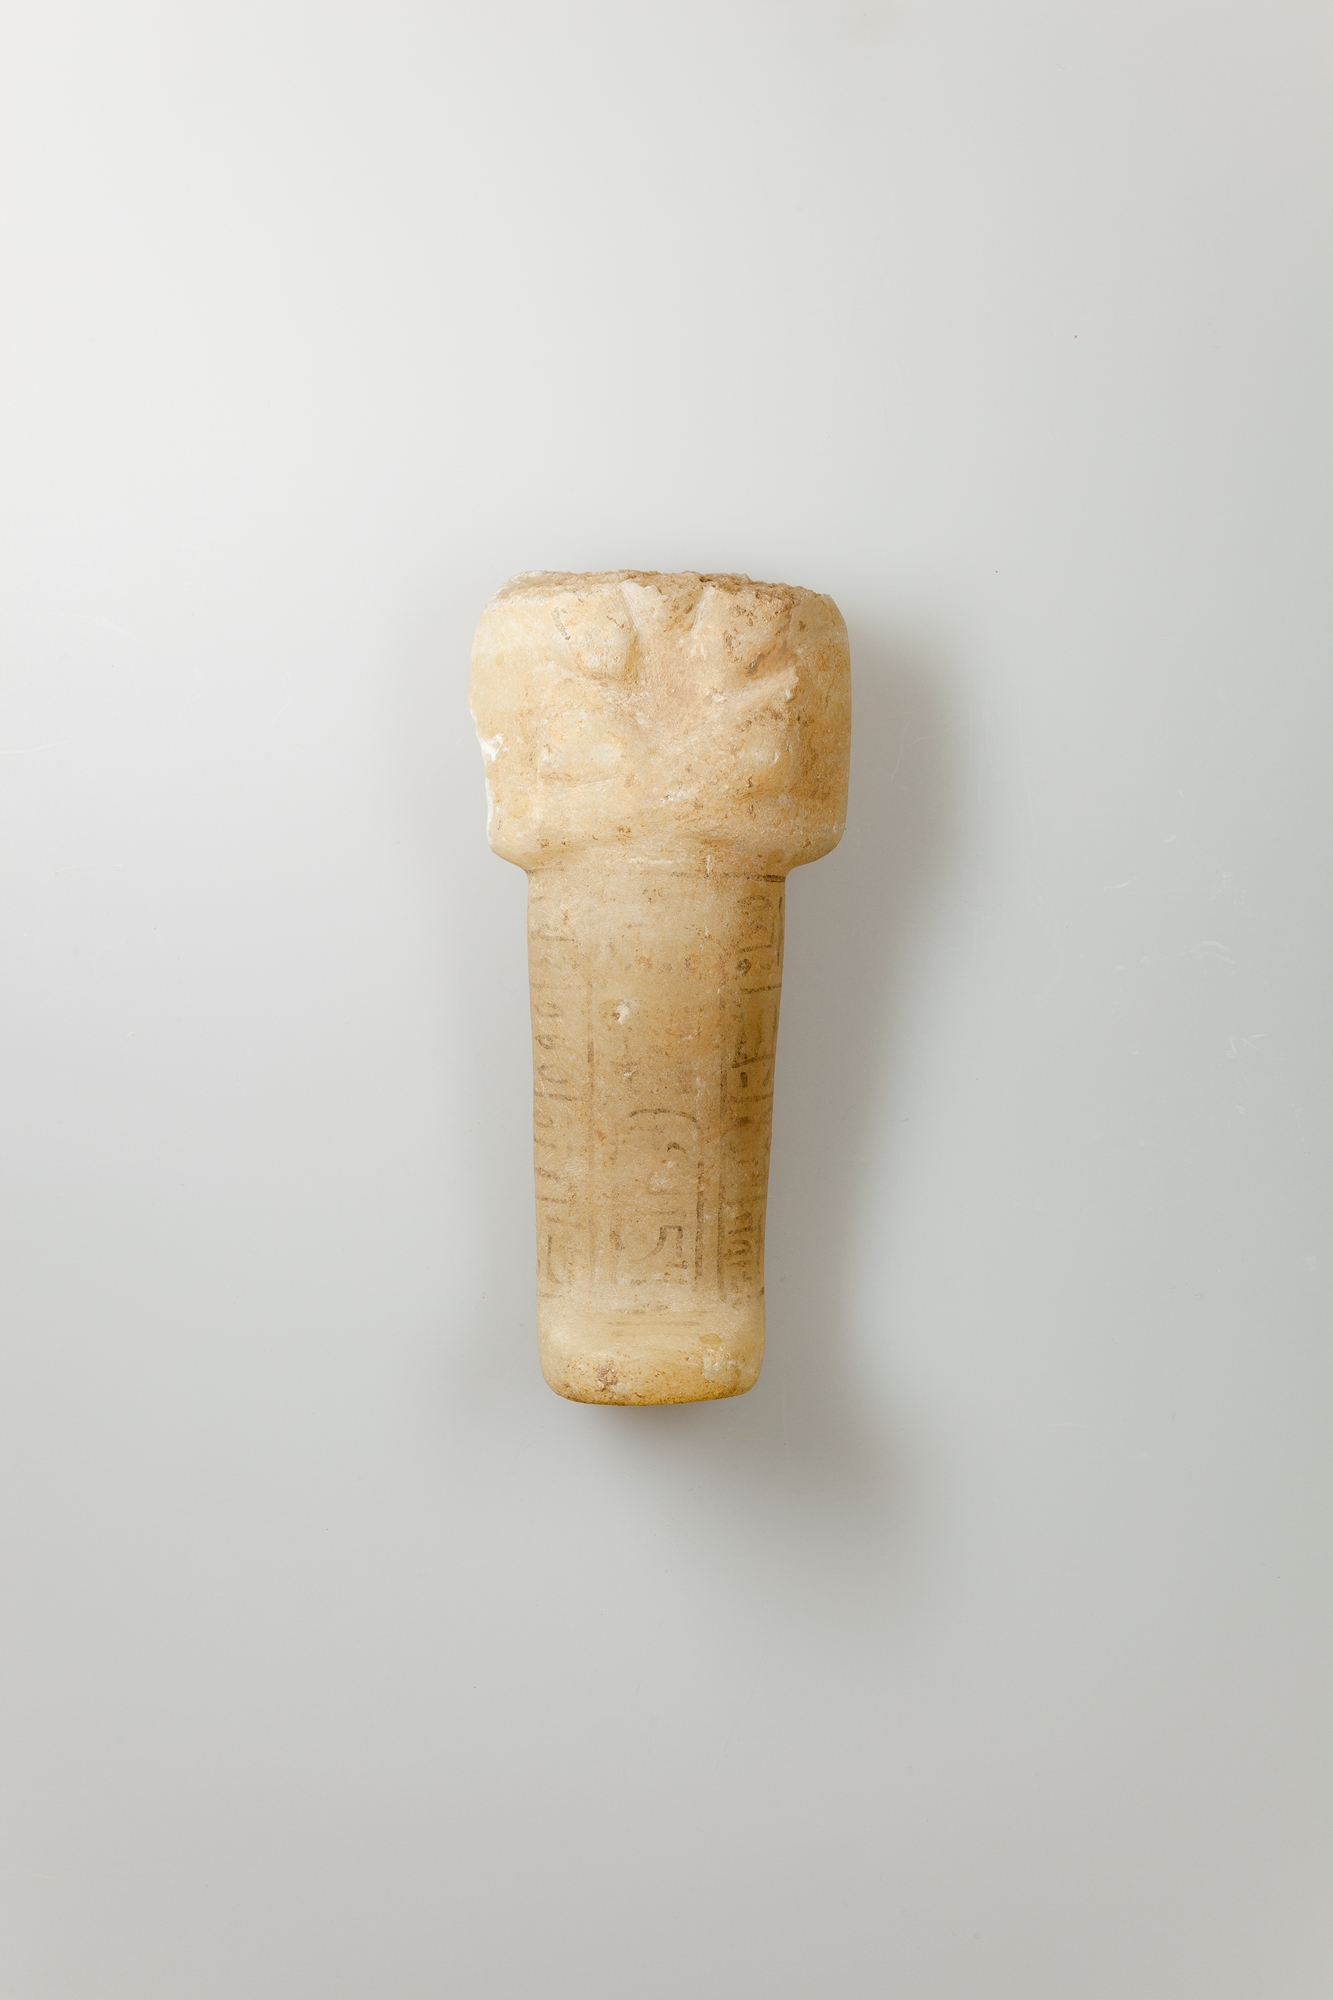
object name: shabti, siptah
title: Shabti of Siptah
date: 1194-1188 BCE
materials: stone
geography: egypt